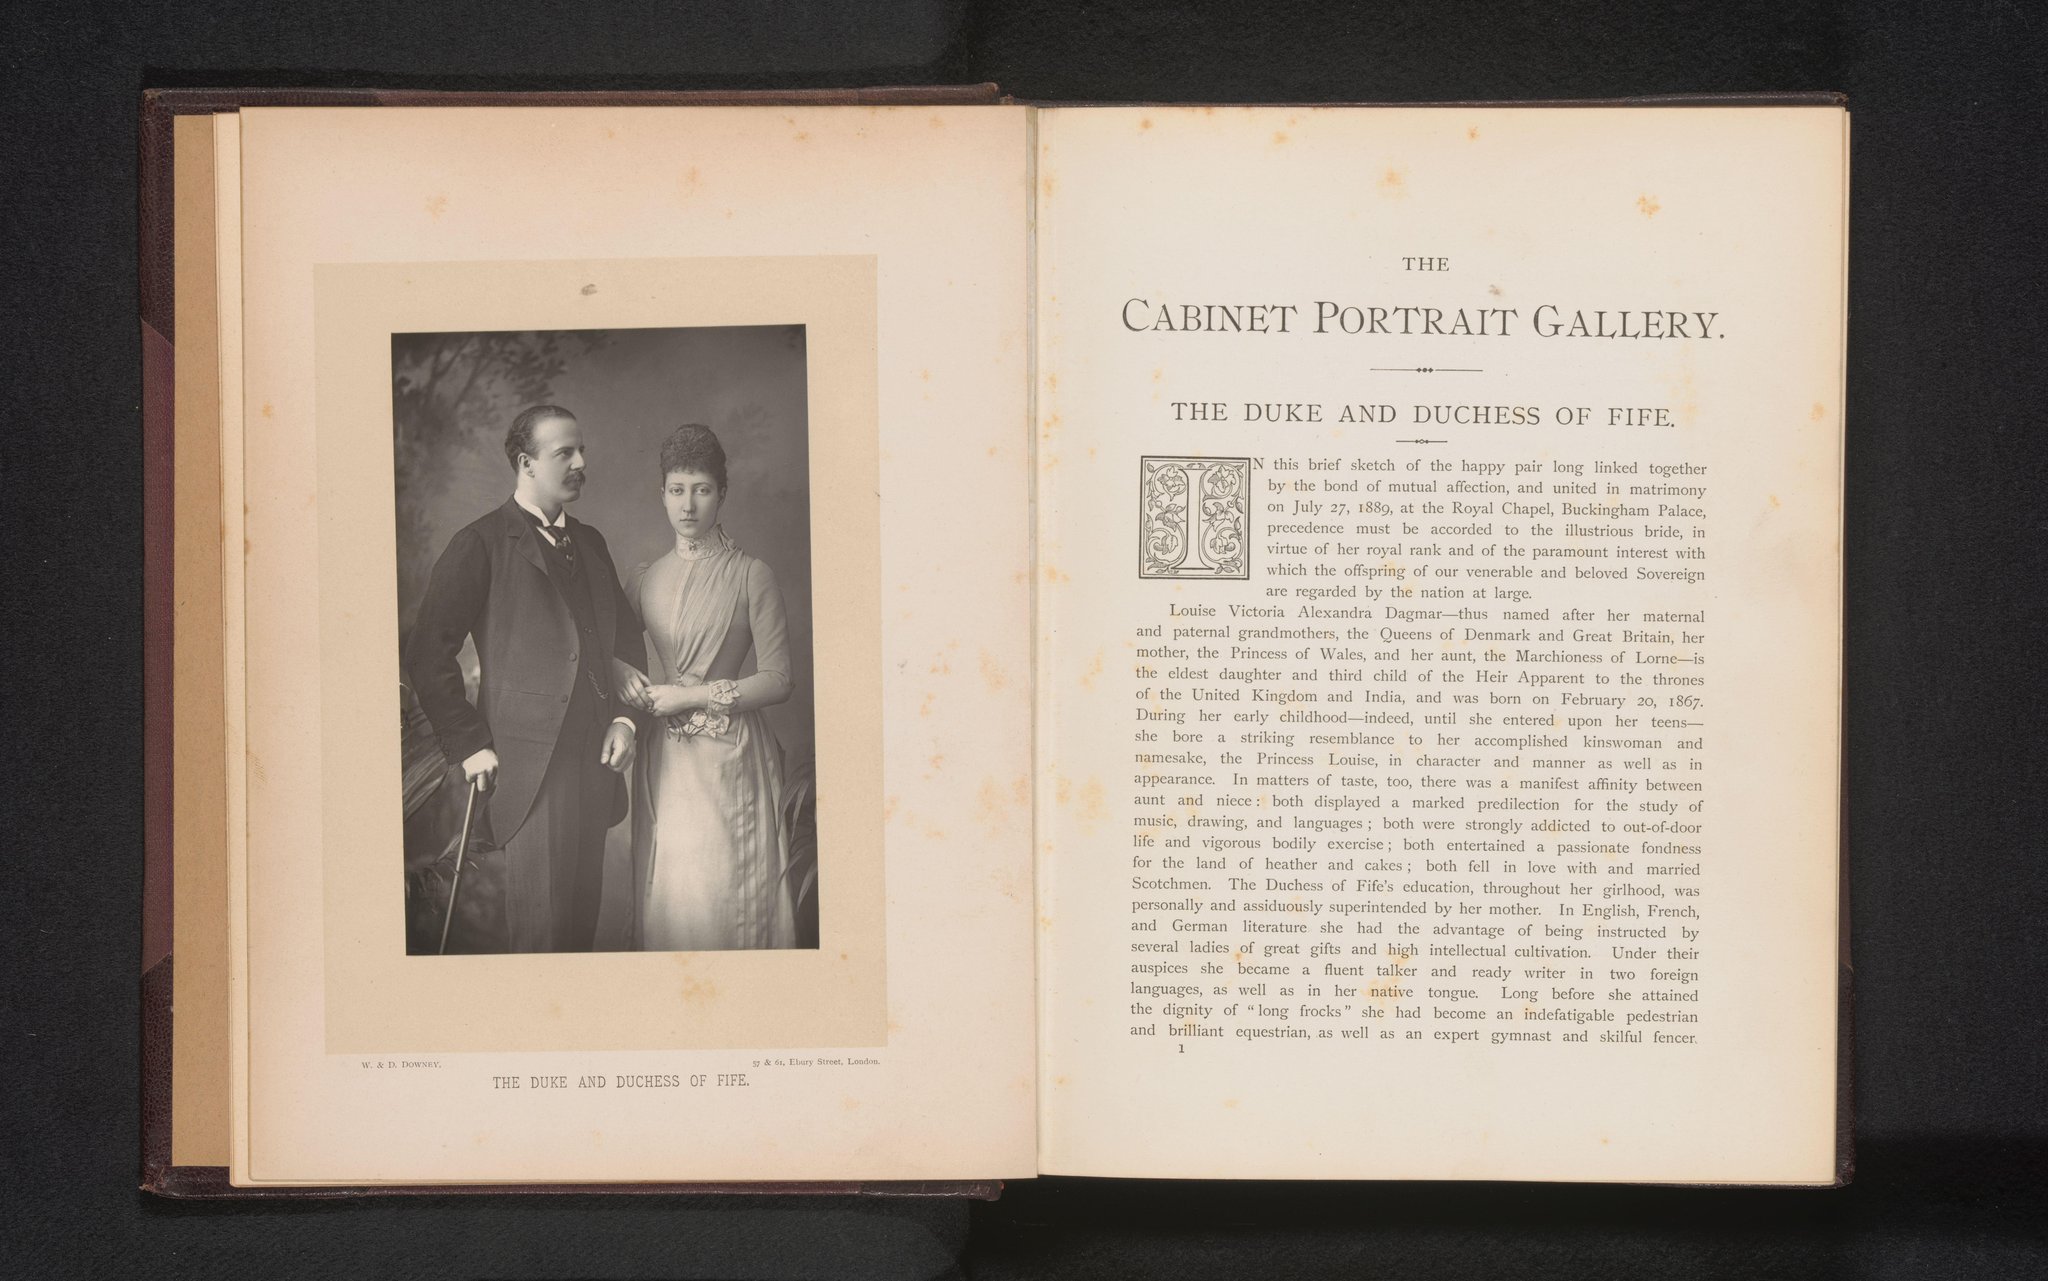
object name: page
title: Portret van Alexander Duff en Louise van Saksen-Coburg de Gotha, de hertog en hertogin van Fife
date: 1885-1890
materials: paper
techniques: carbon print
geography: london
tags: london, historical persons - bb - woman, historical persons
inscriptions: address: ‘57 & 61, Elbury Street, London.’